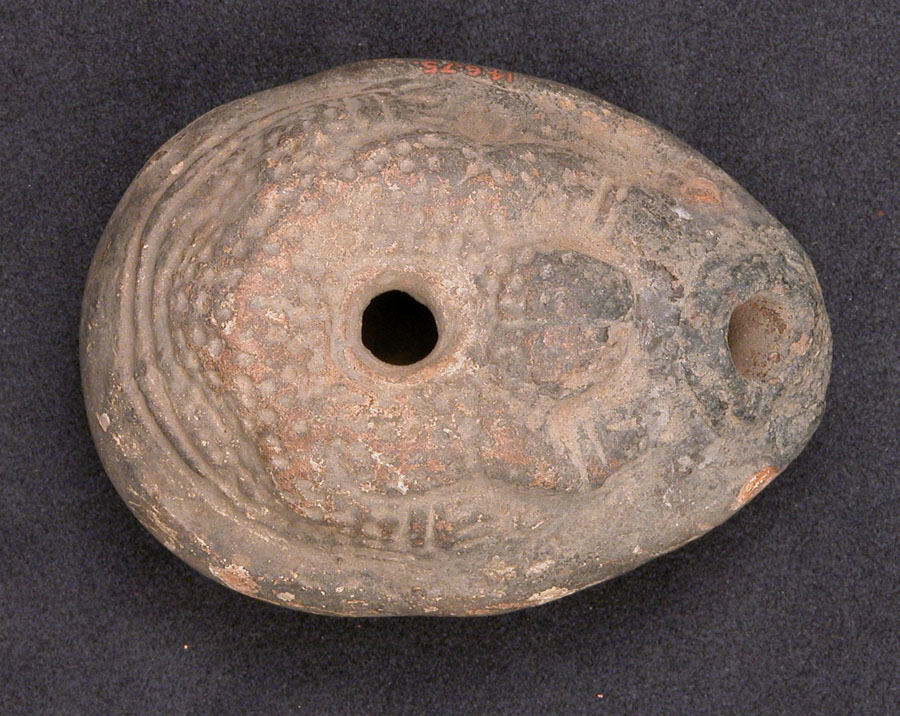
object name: lamp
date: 201-800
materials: earthenware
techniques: molding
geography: egypt